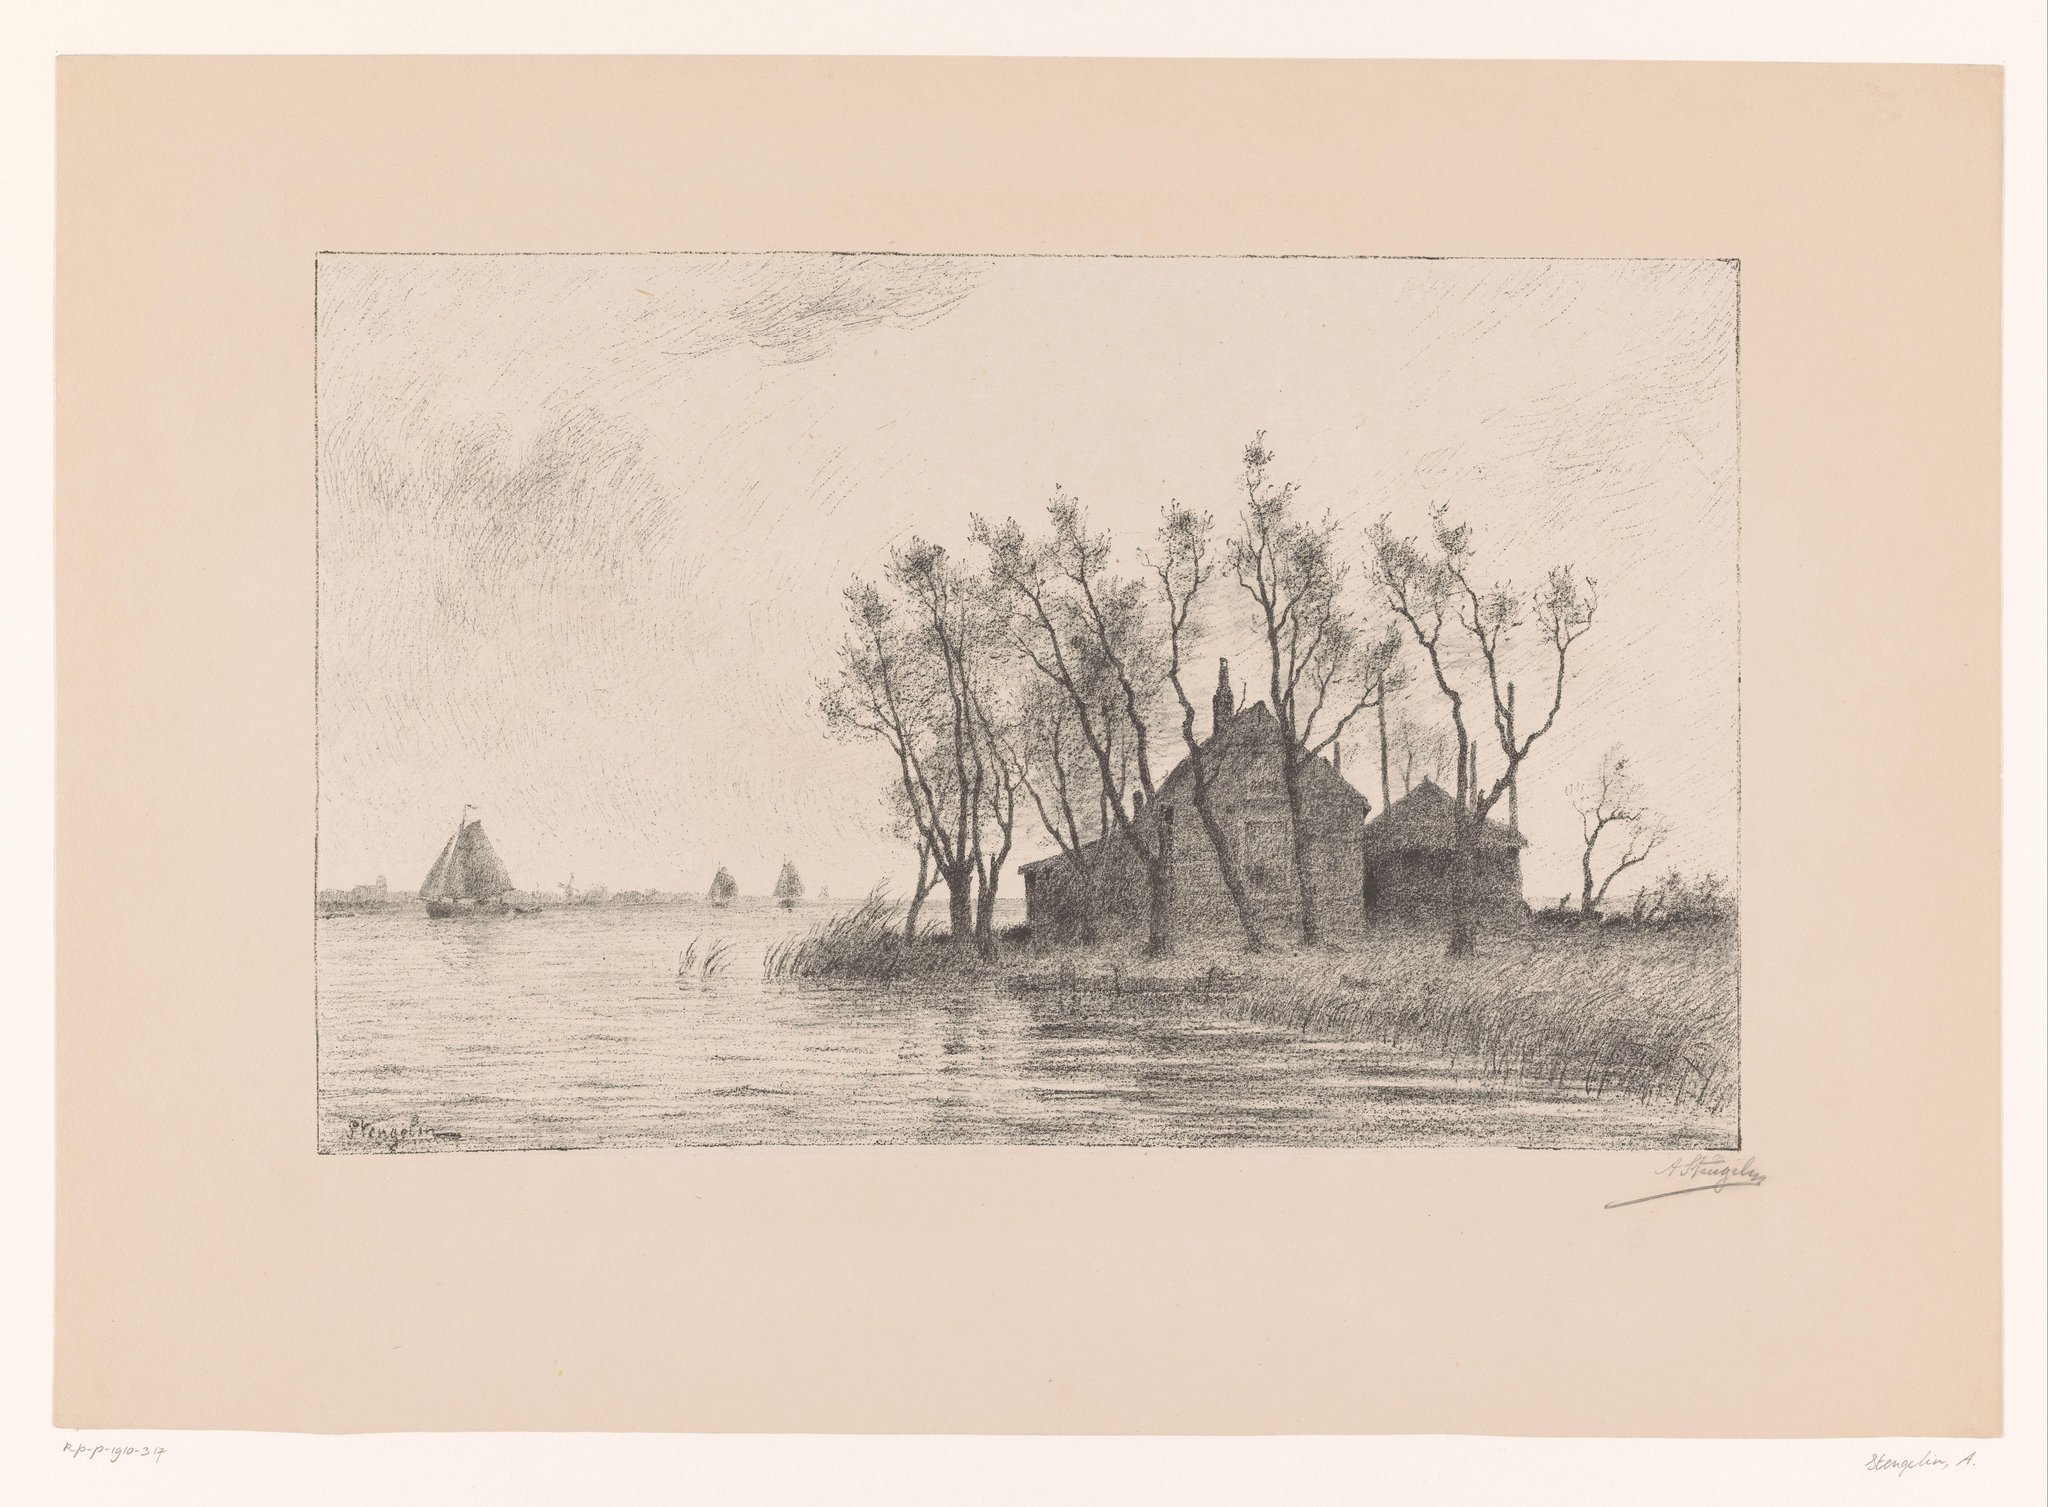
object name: print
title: La ferme dans les saules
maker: alphonse stengelin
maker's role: painter, print maker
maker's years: 1852-1938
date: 1876-1910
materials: paper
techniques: lithograph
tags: river, landscapes with waters, waterscapes, seascapes (in the temperate zone), hay-stack, trees: willow, farm (building)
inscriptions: collector's mark: Lugt 2228, inscription: ‘29-30’